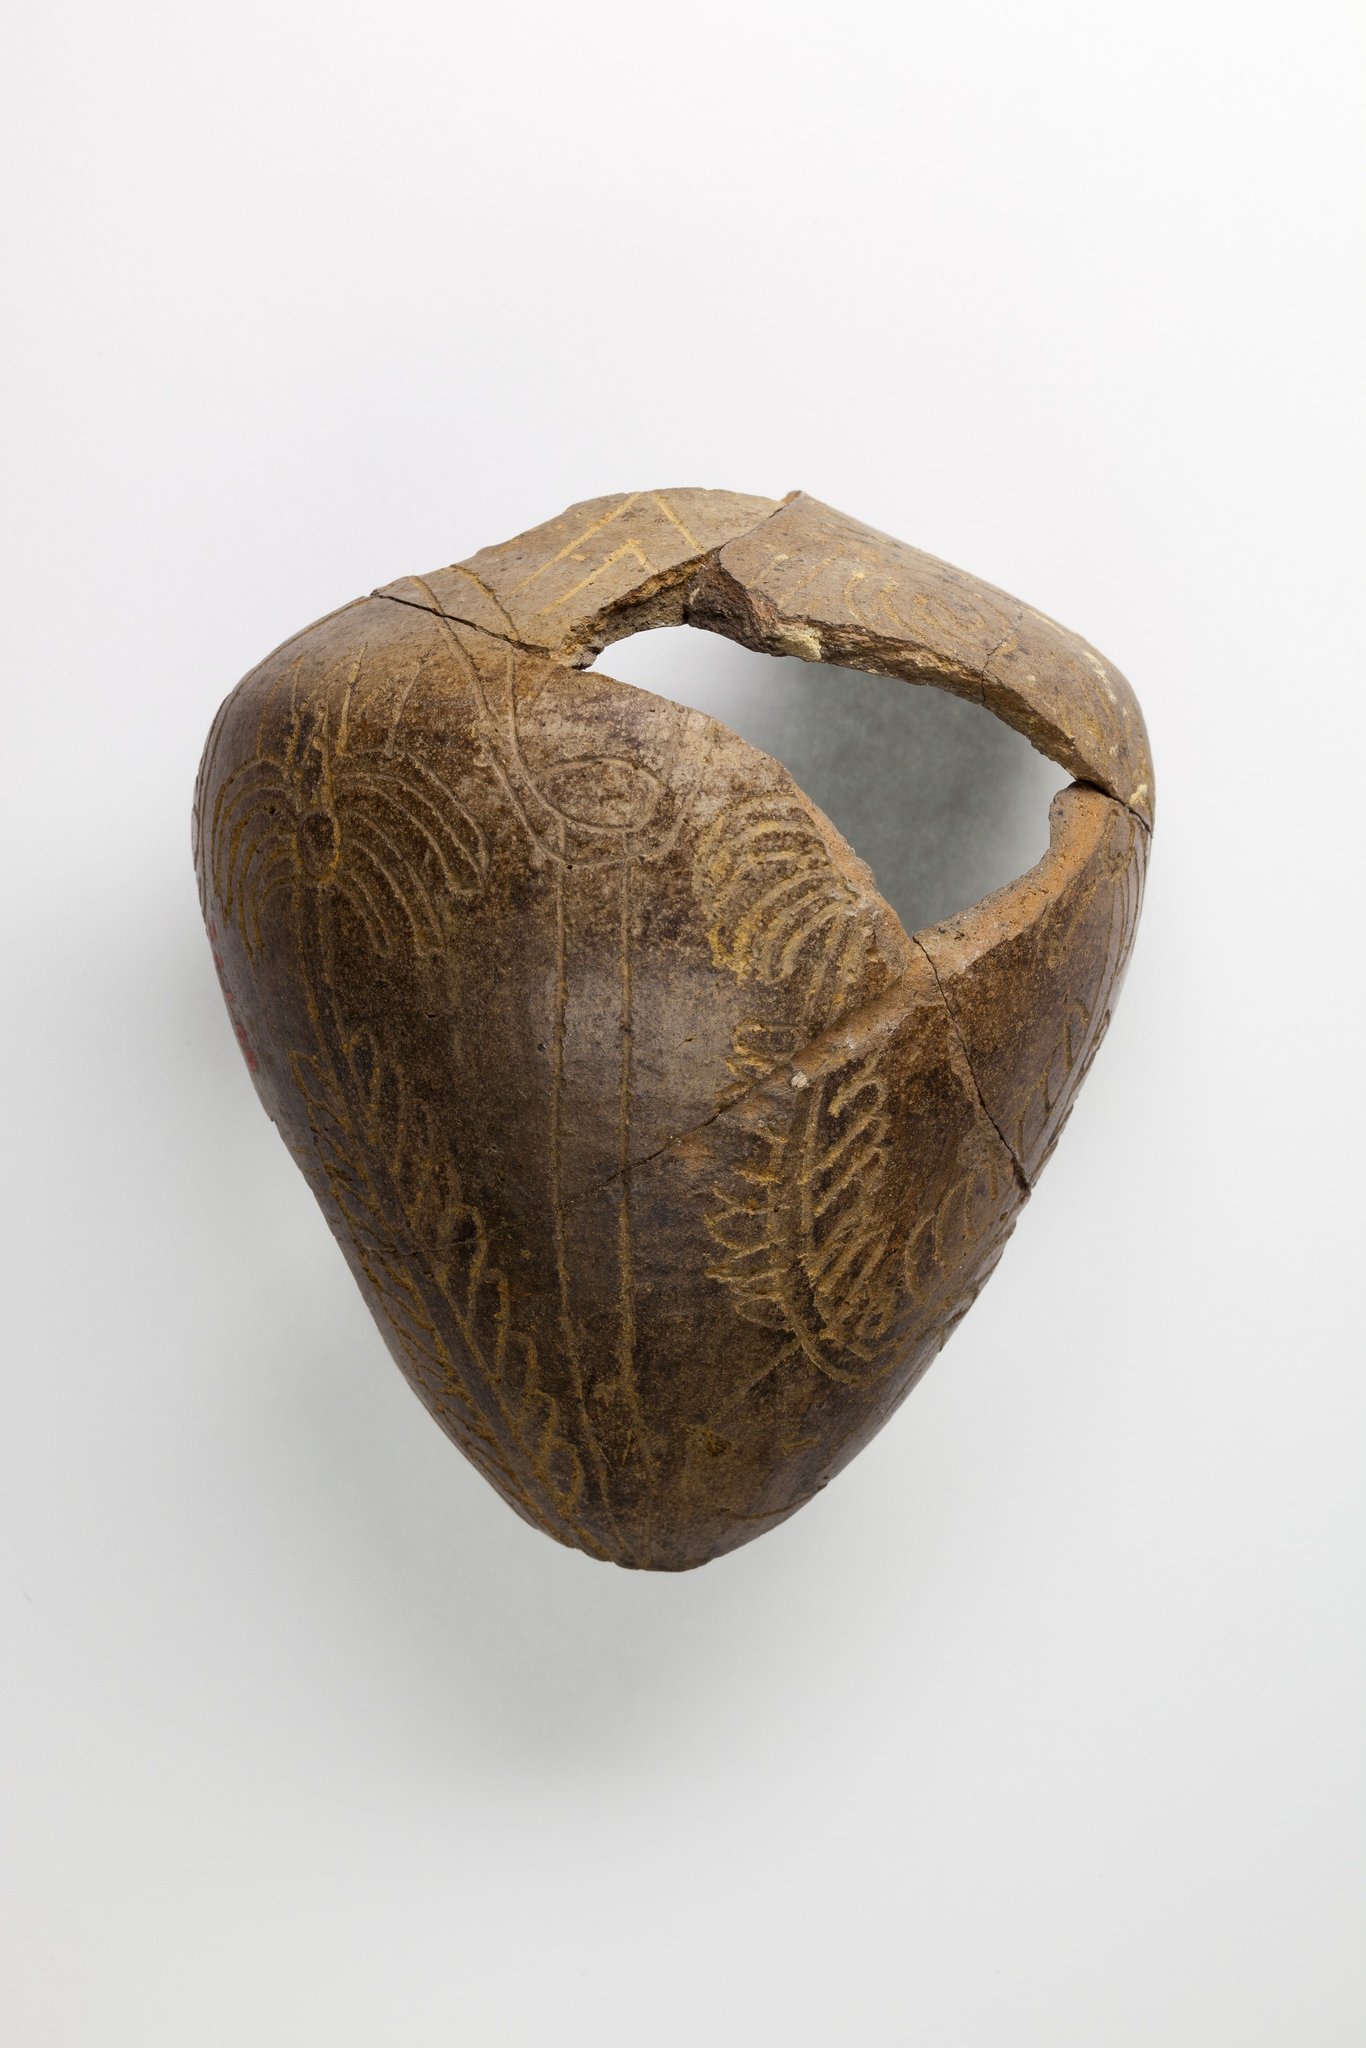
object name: jar, tell el yahudiya ware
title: Tell el-Yahudiya-ware jar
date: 1750-1600 BCE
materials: pottery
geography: egypt